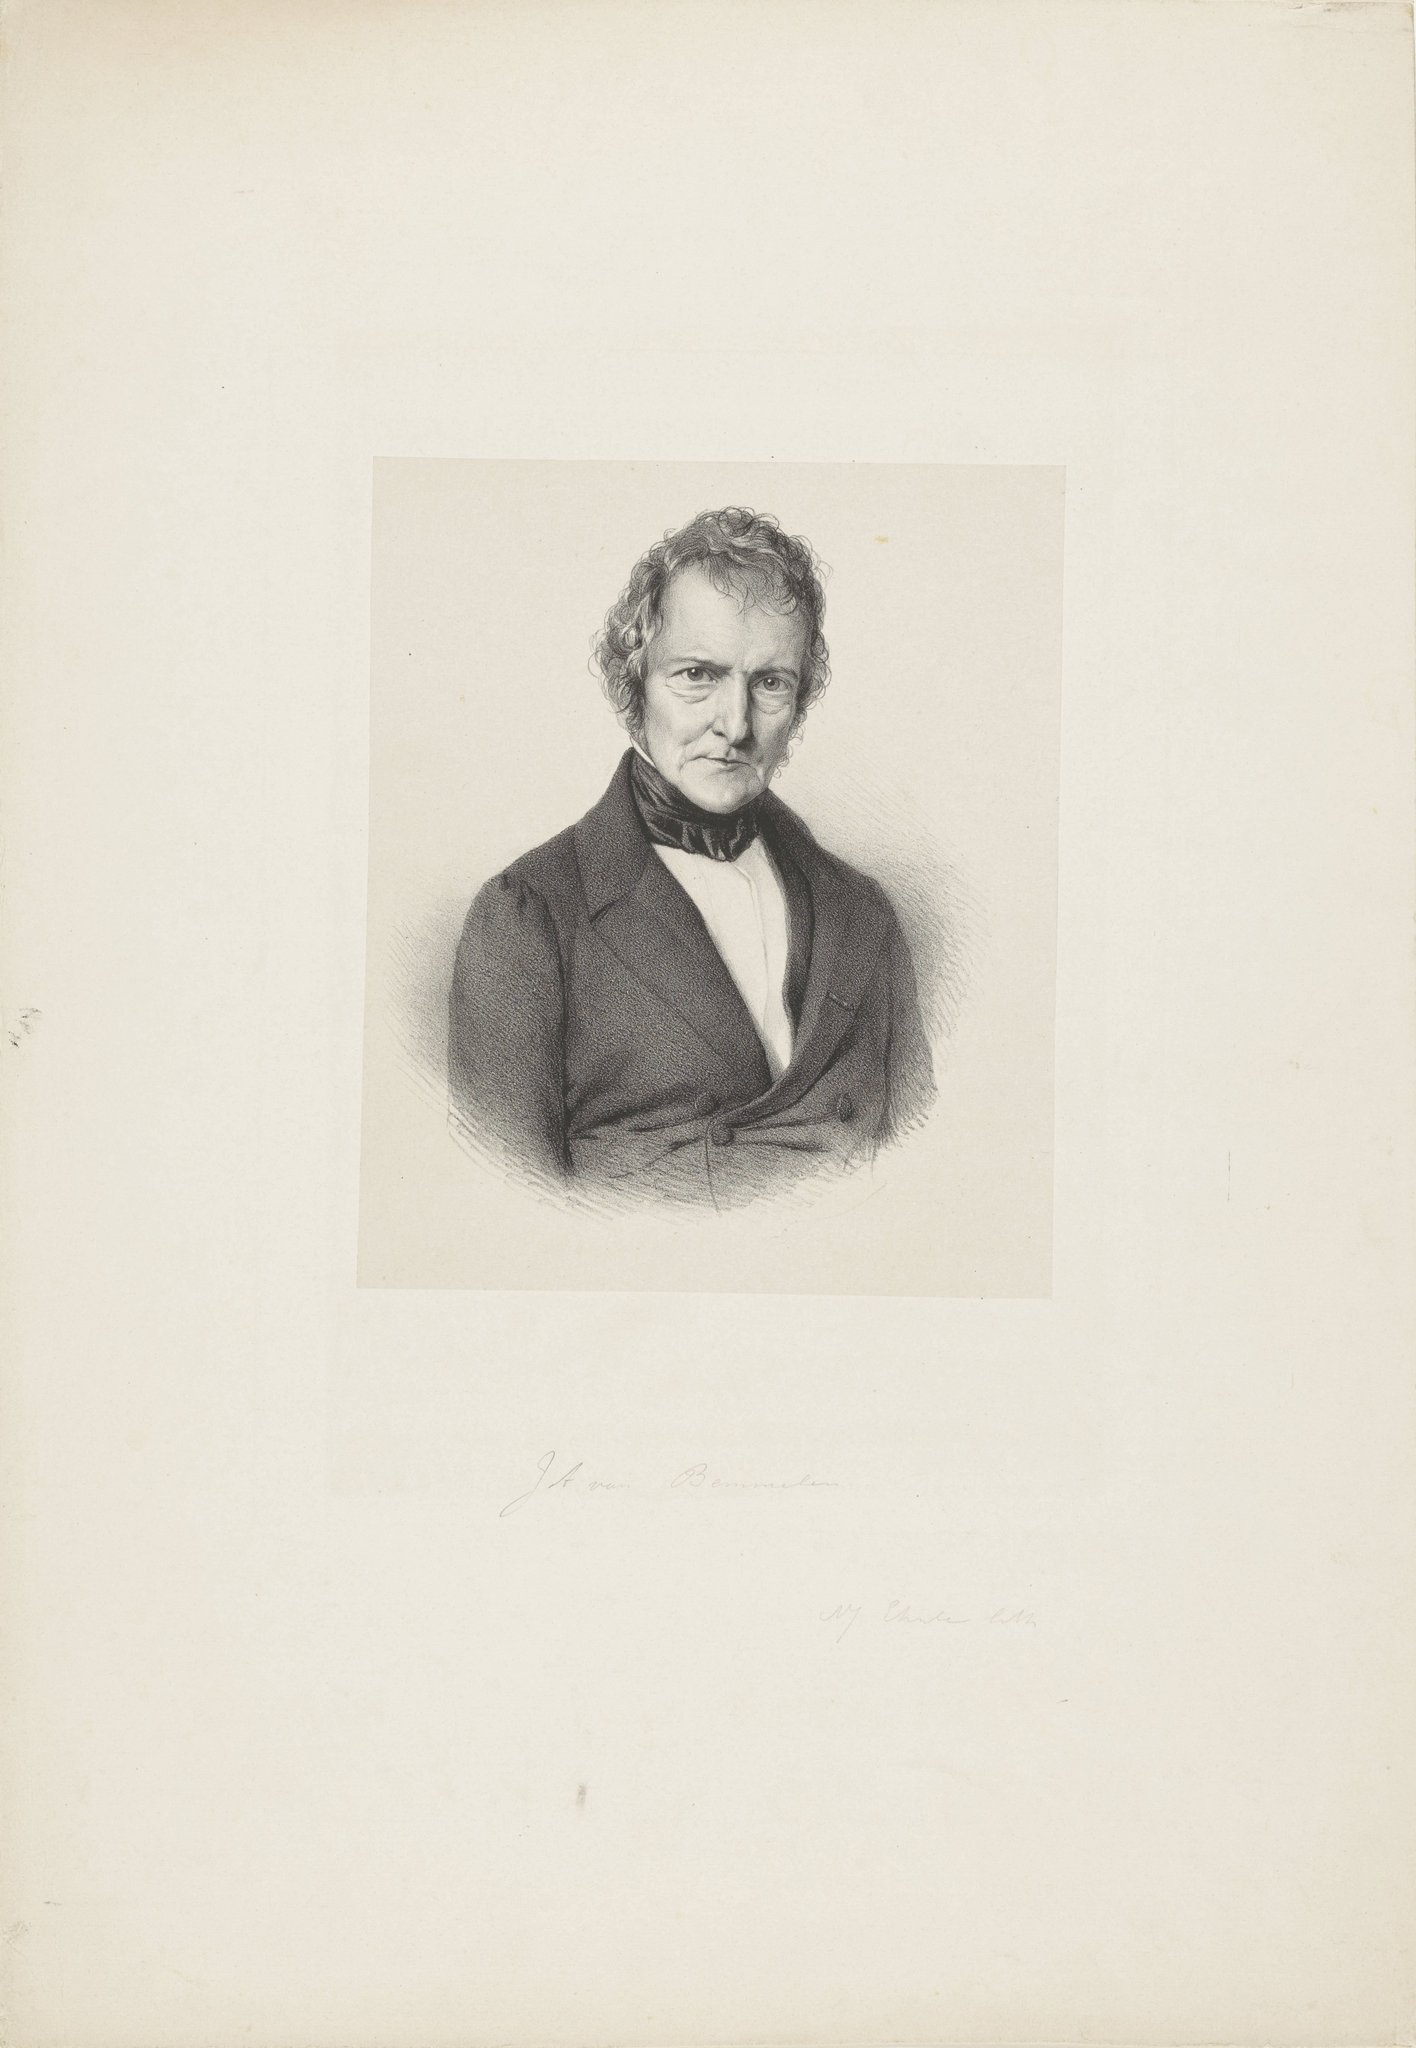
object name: print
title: Portret van J.A. van Bemmelen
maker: adrianus johannes ehnle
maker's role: draughtsman, print maker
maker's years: 1819-1863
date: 1829-1853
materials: paper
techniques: lithograph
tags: historical persons (+ (full) bust portrait)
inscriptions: collector's mark: Lugt 2228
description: De geportretteerde heeft het hoofd licht gebogen.